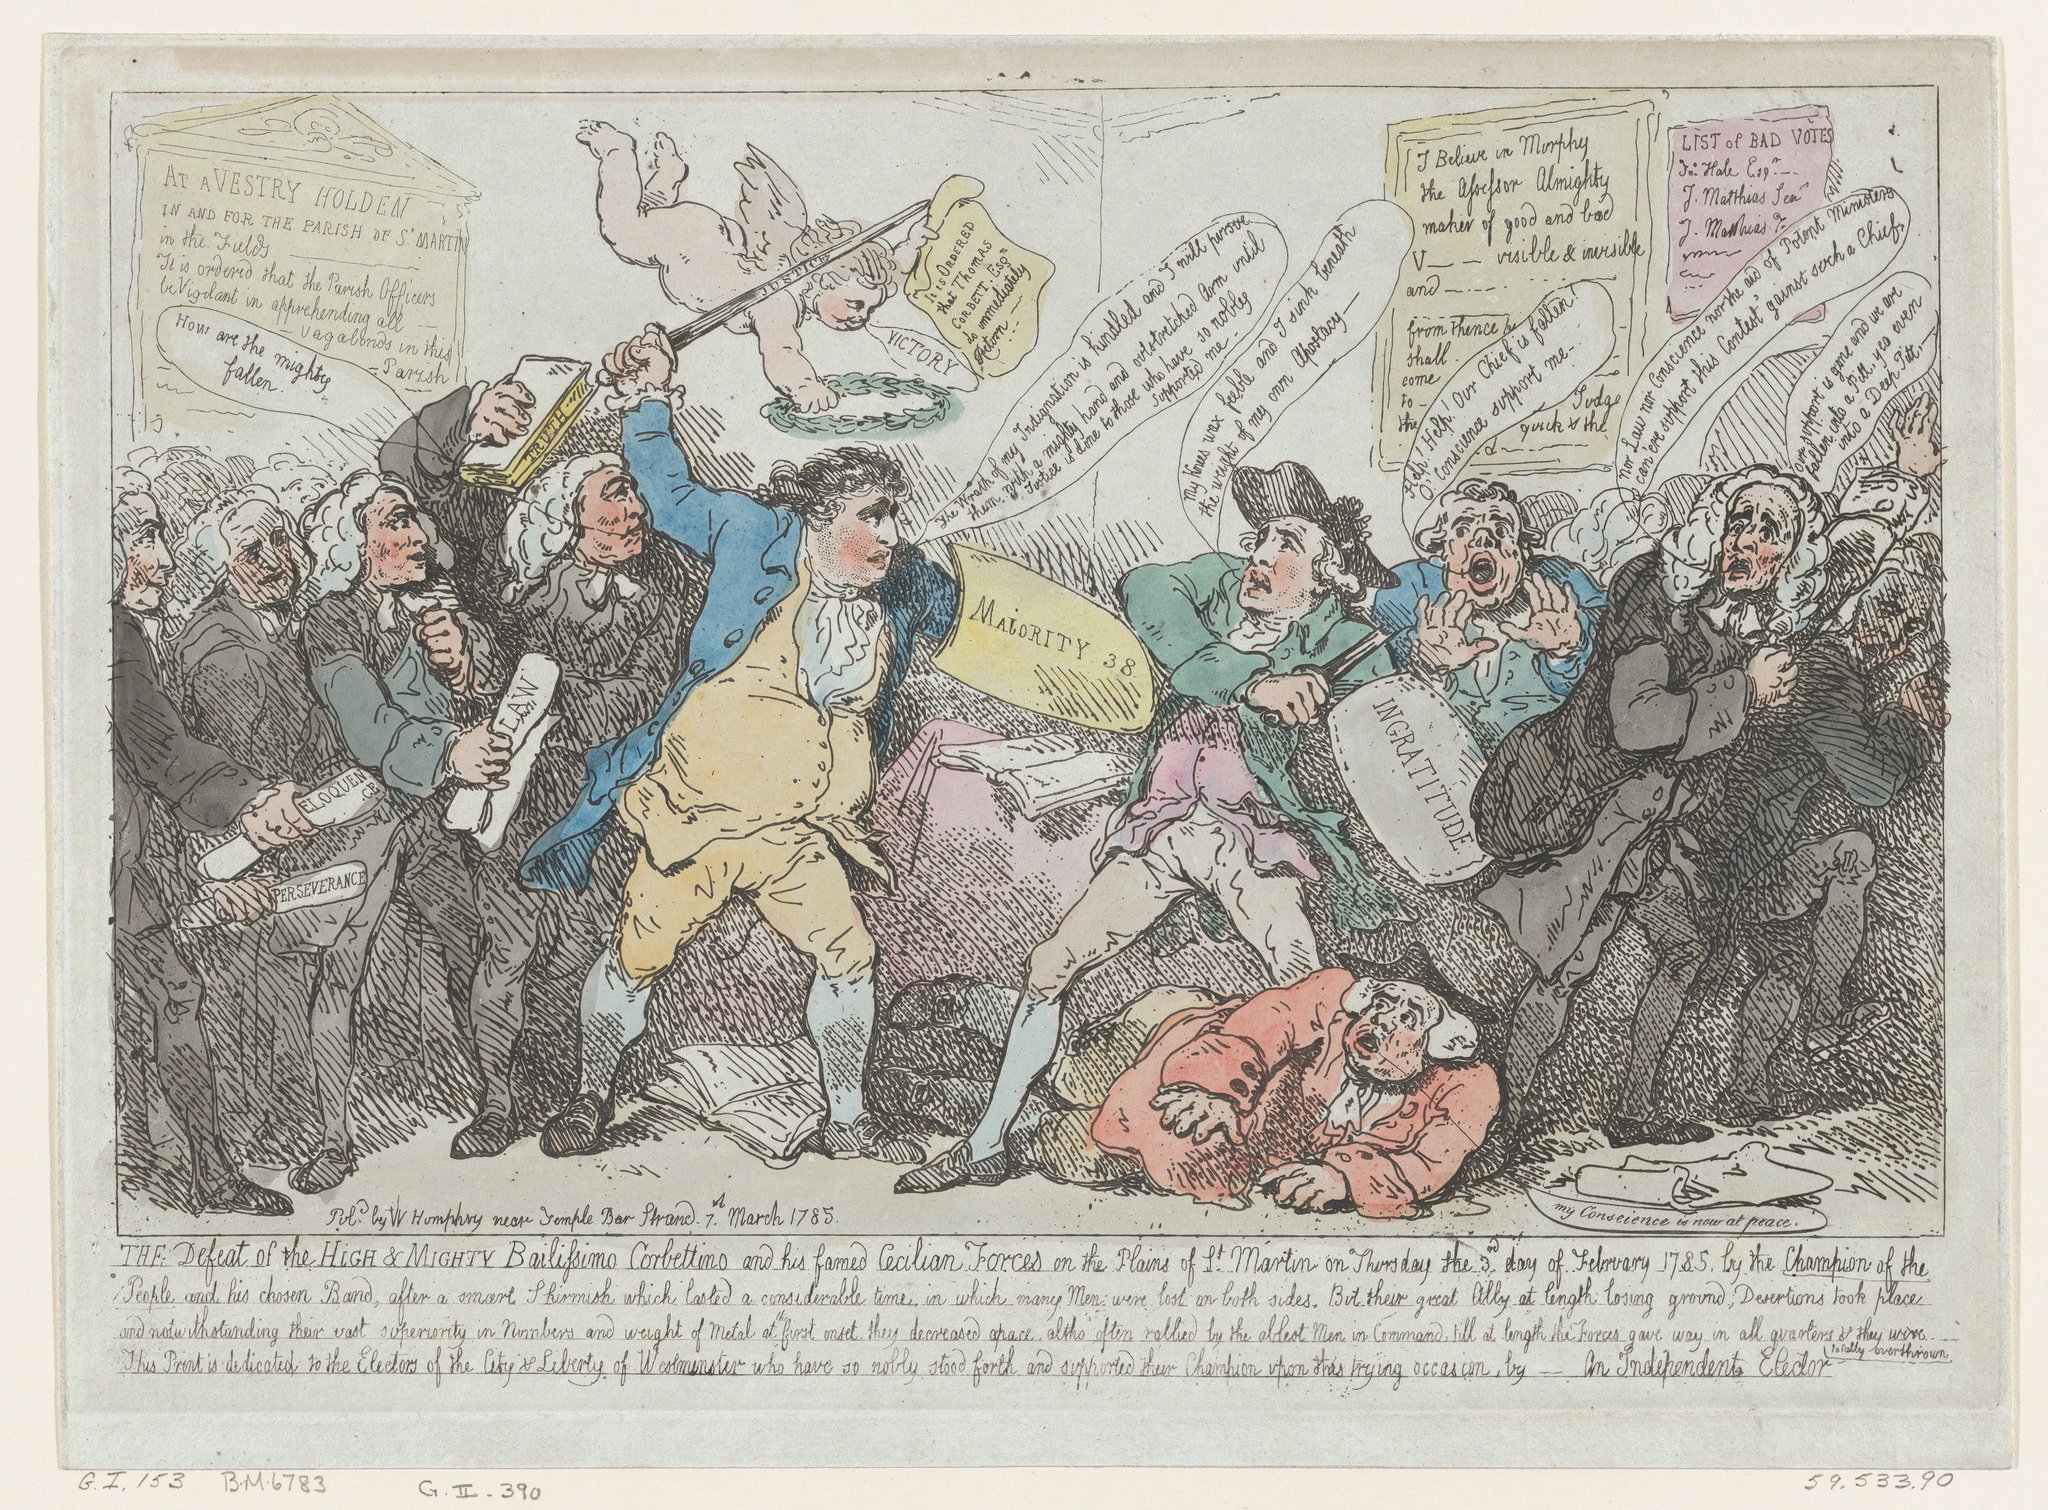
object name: print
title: The Defeat of the High & Mighty Bailissimo Corbettino...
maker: thomas rowlandson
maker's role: artist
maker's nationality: british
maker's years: 1757-1827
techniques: etching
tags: satire,men